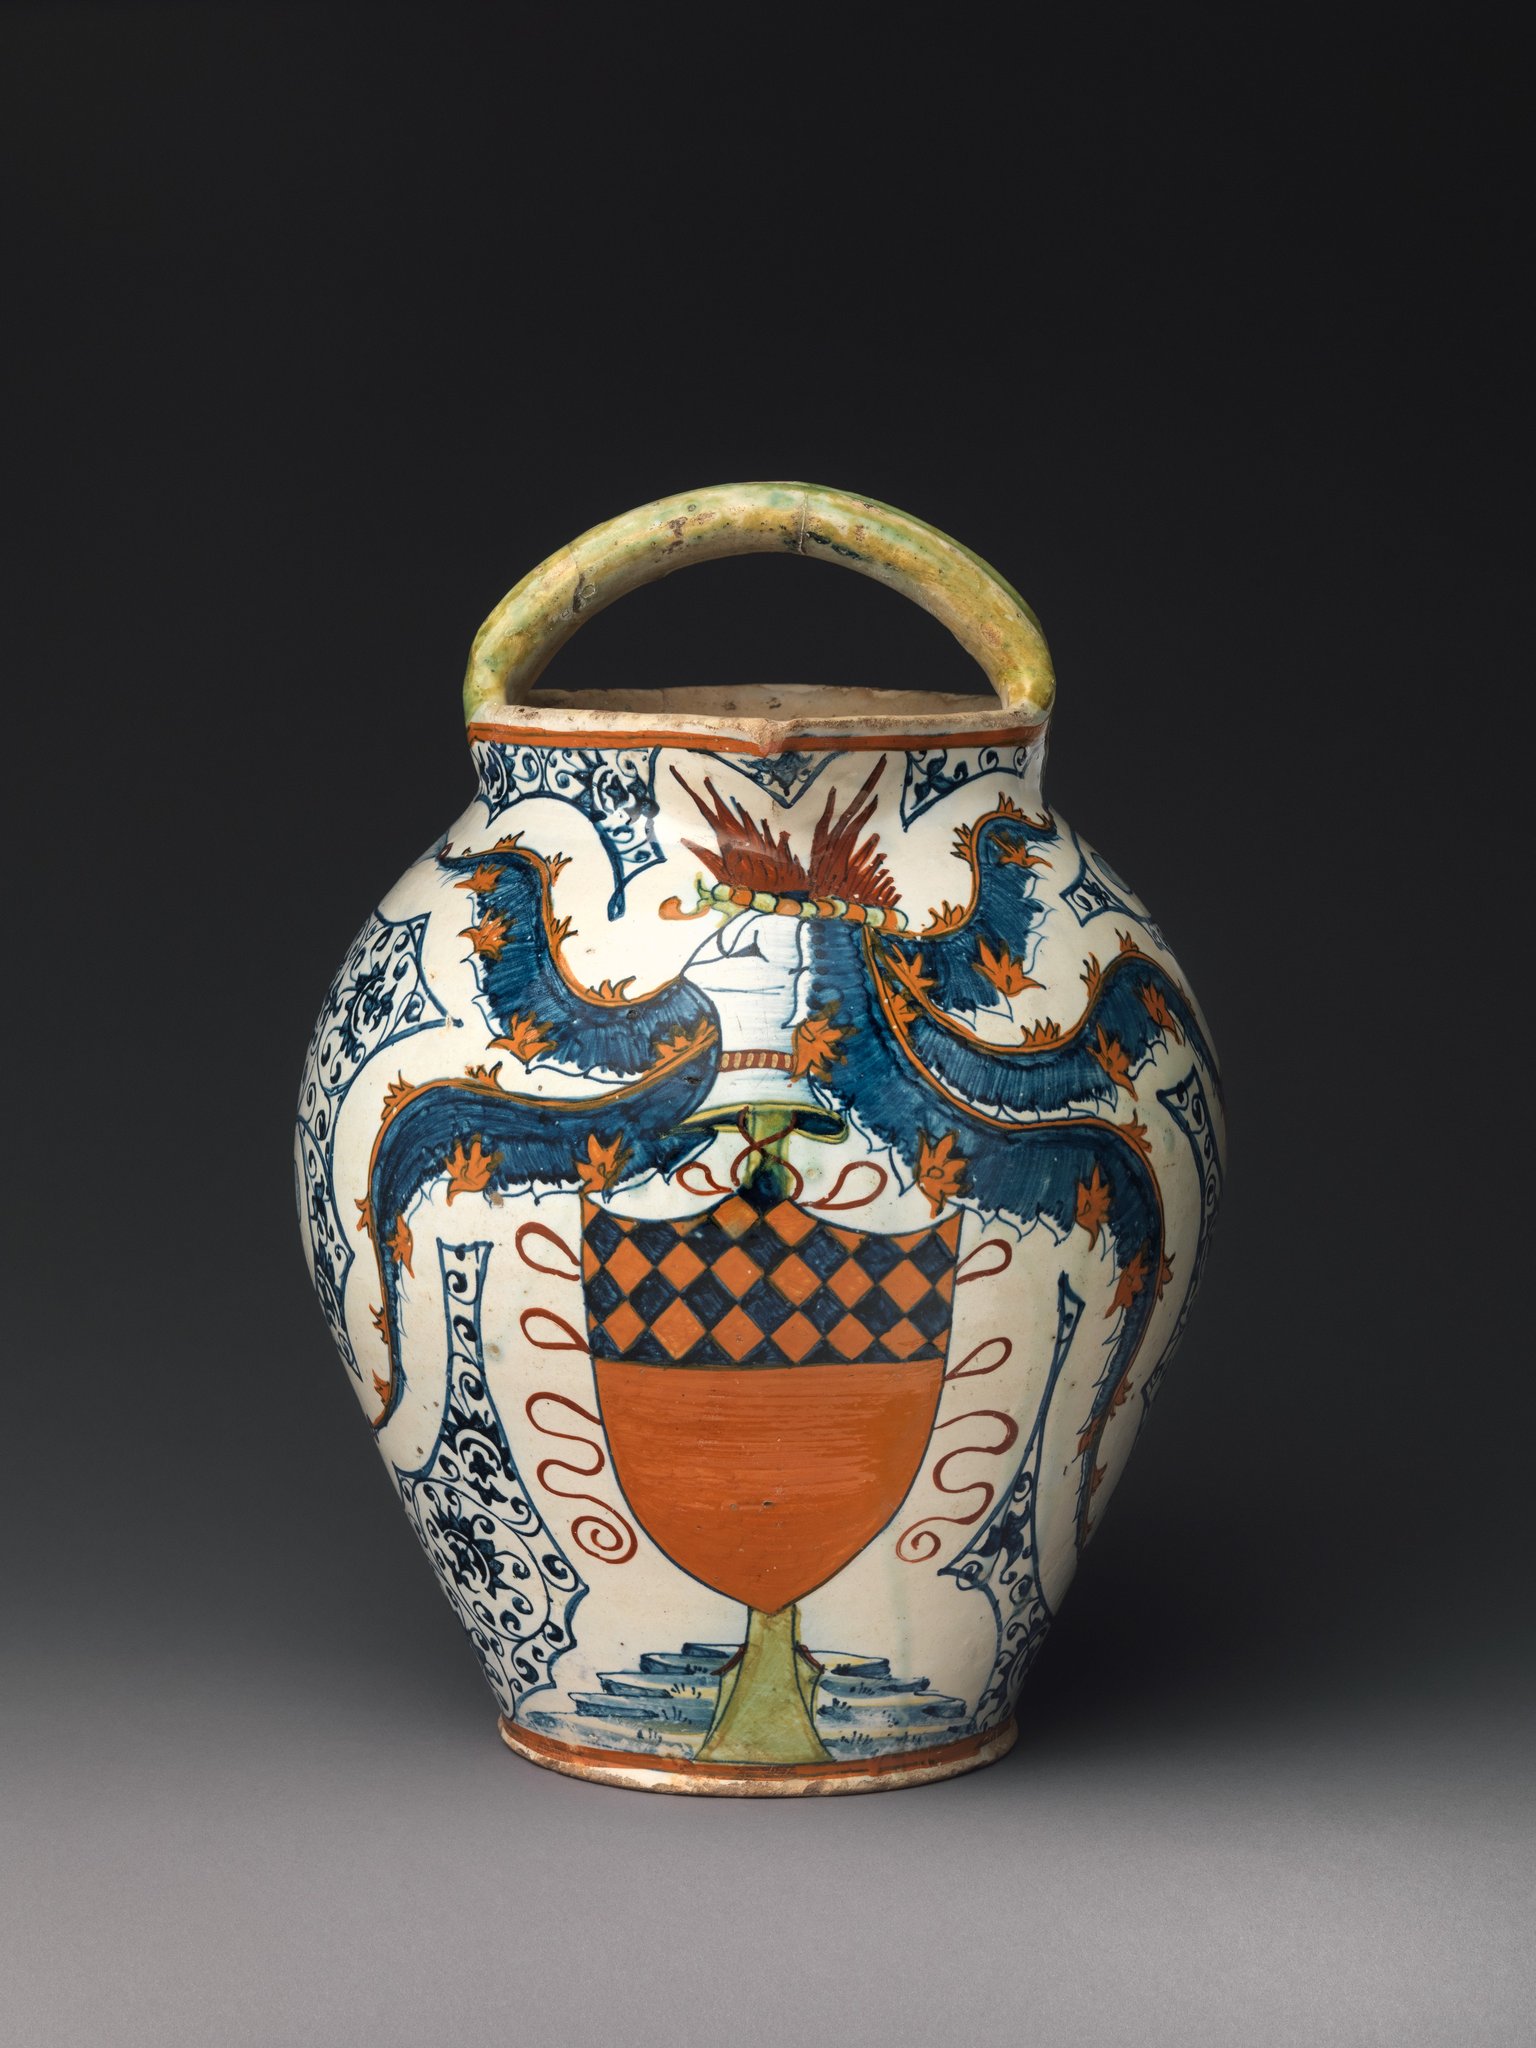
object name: pitcher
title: Double-spouted pitcher with arms of the Antinori family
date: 1505-1515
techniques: maiolica, glazing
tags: coat of arms